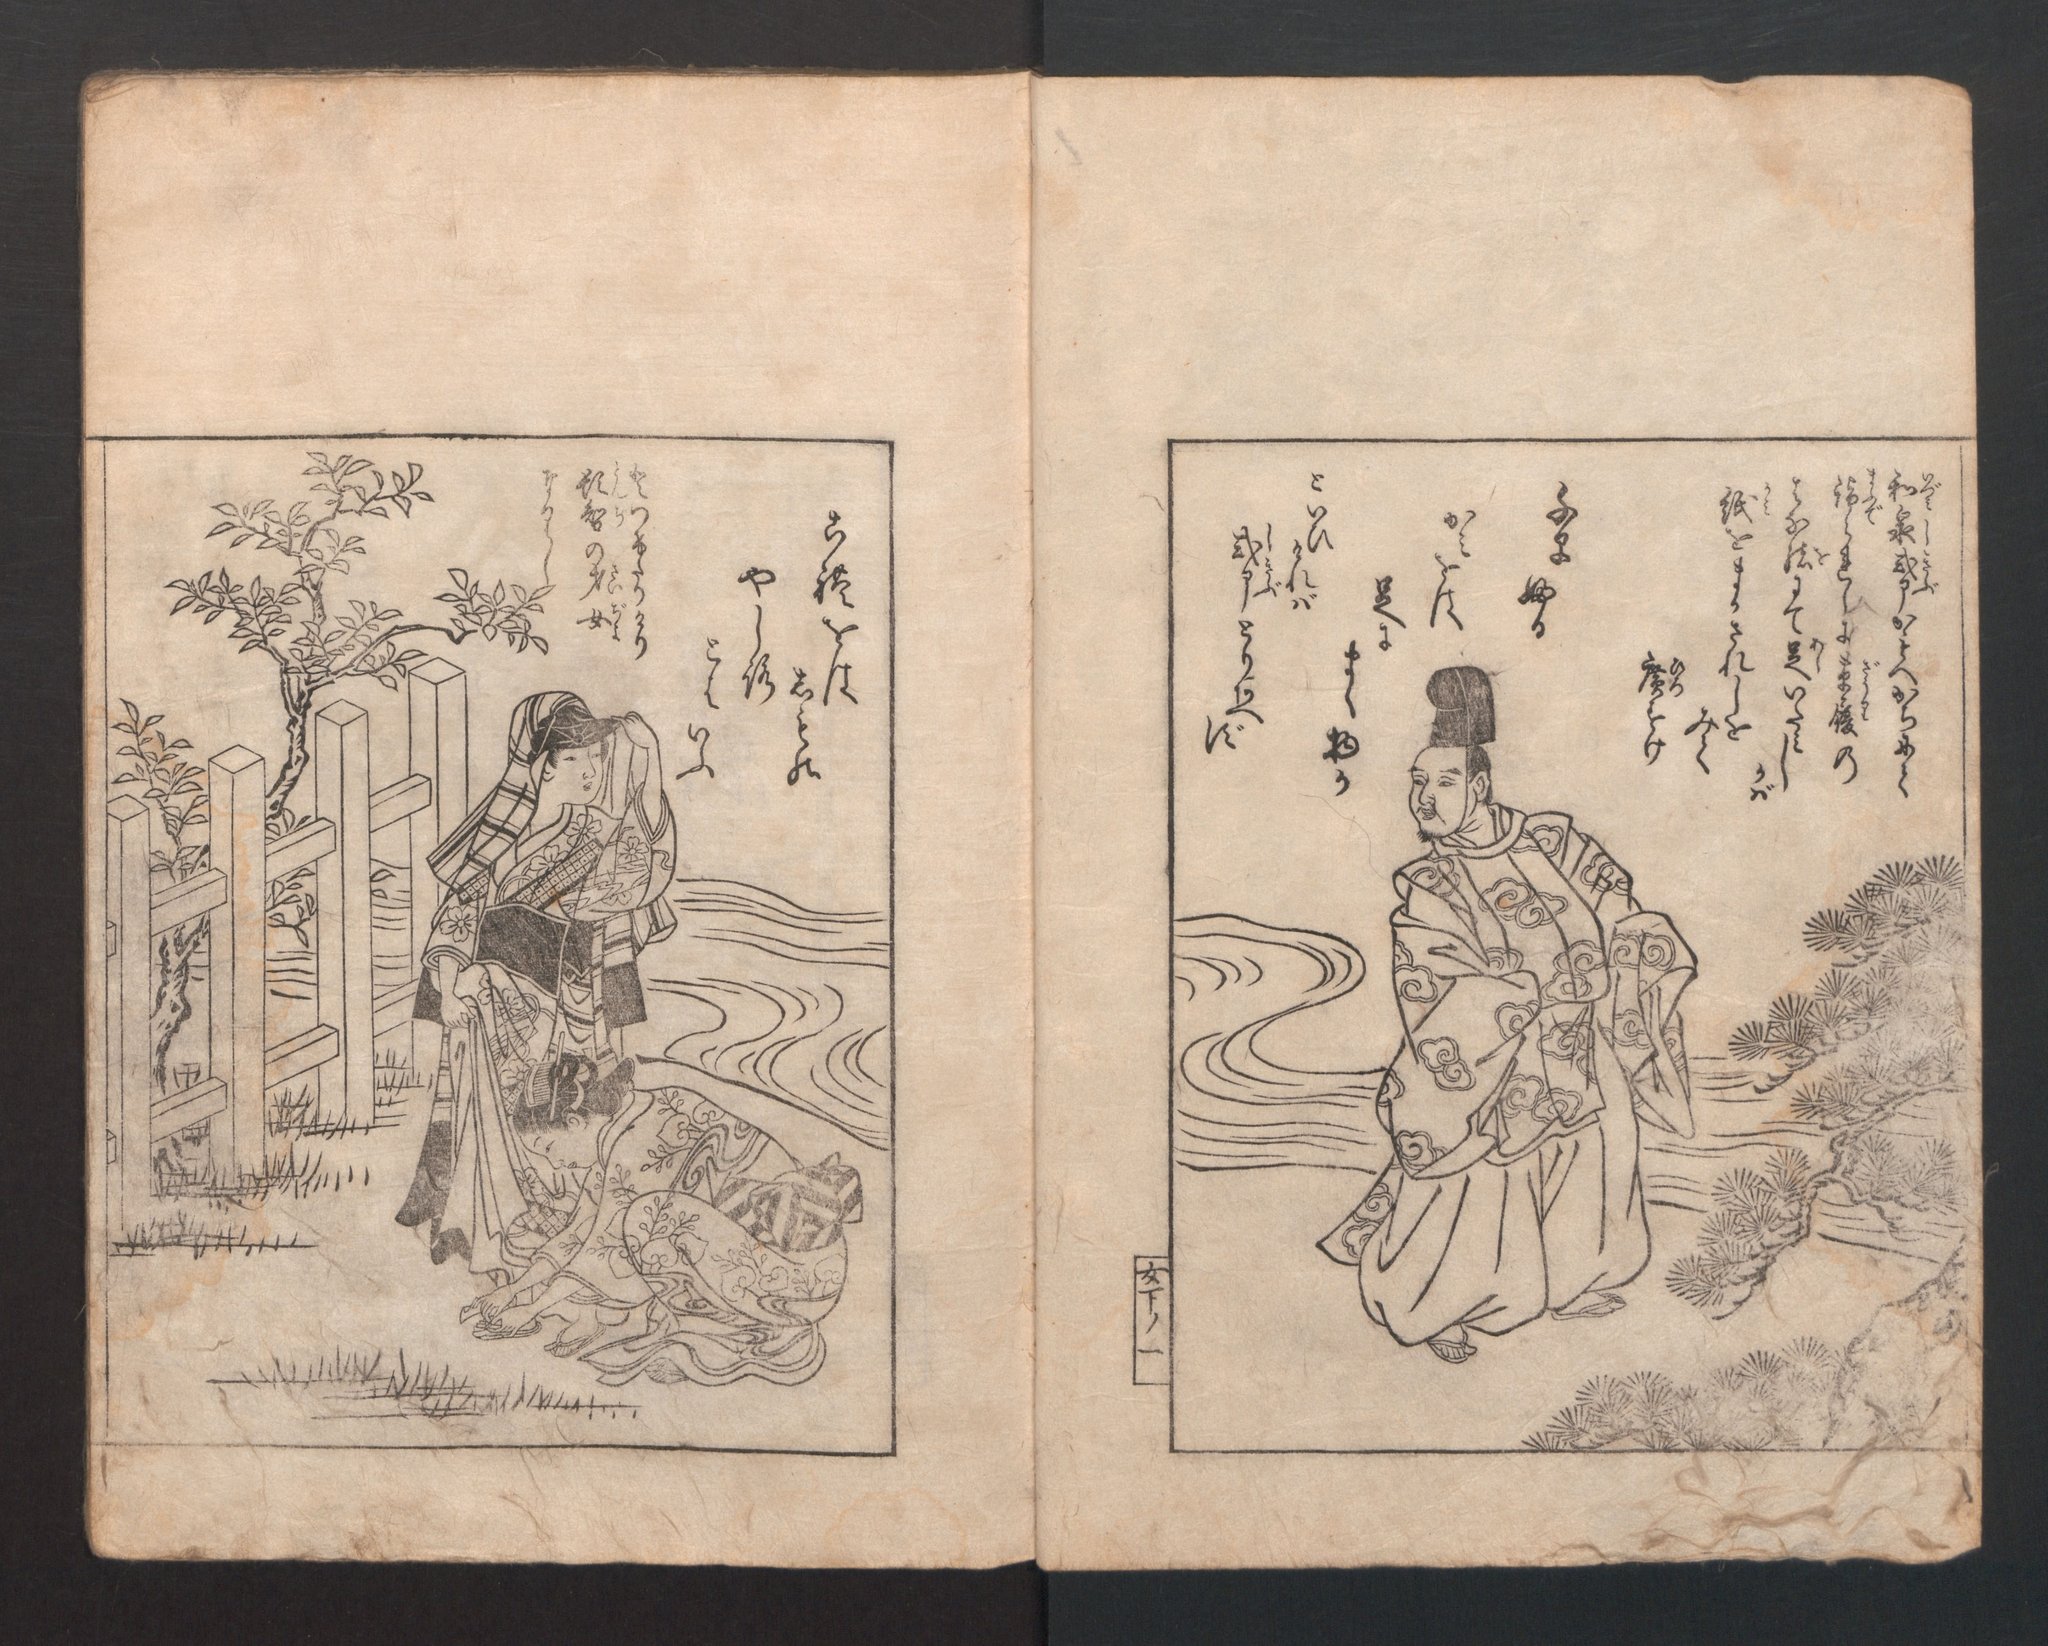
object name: illustrated book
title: Picture Book: Camellia (Ehon Himetsubaki) 絵本女貞木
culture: japanese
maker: nishikawa sukenobu 西川祐信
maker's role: artist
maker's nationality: japanese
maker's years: 1671-1750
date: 1745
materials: ink, paper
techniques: bookbinding, woodblock print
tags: men,women